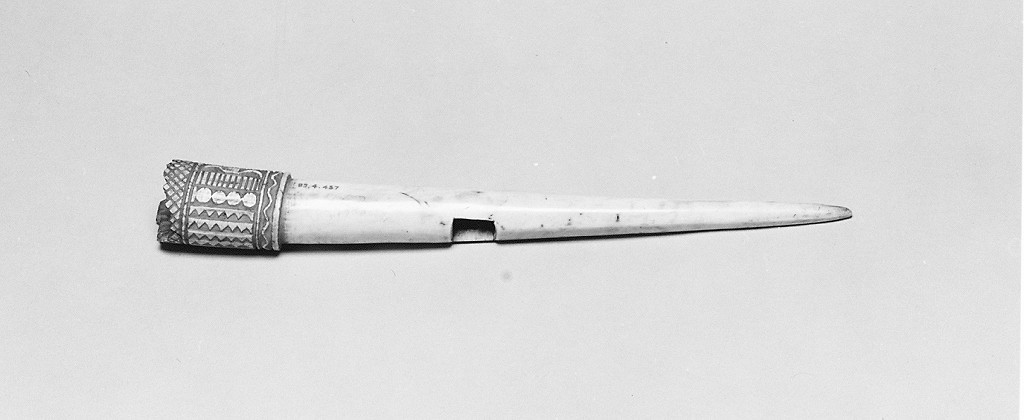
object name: horn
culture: tanzanian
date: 1867-1900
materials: ivory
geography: tanzania